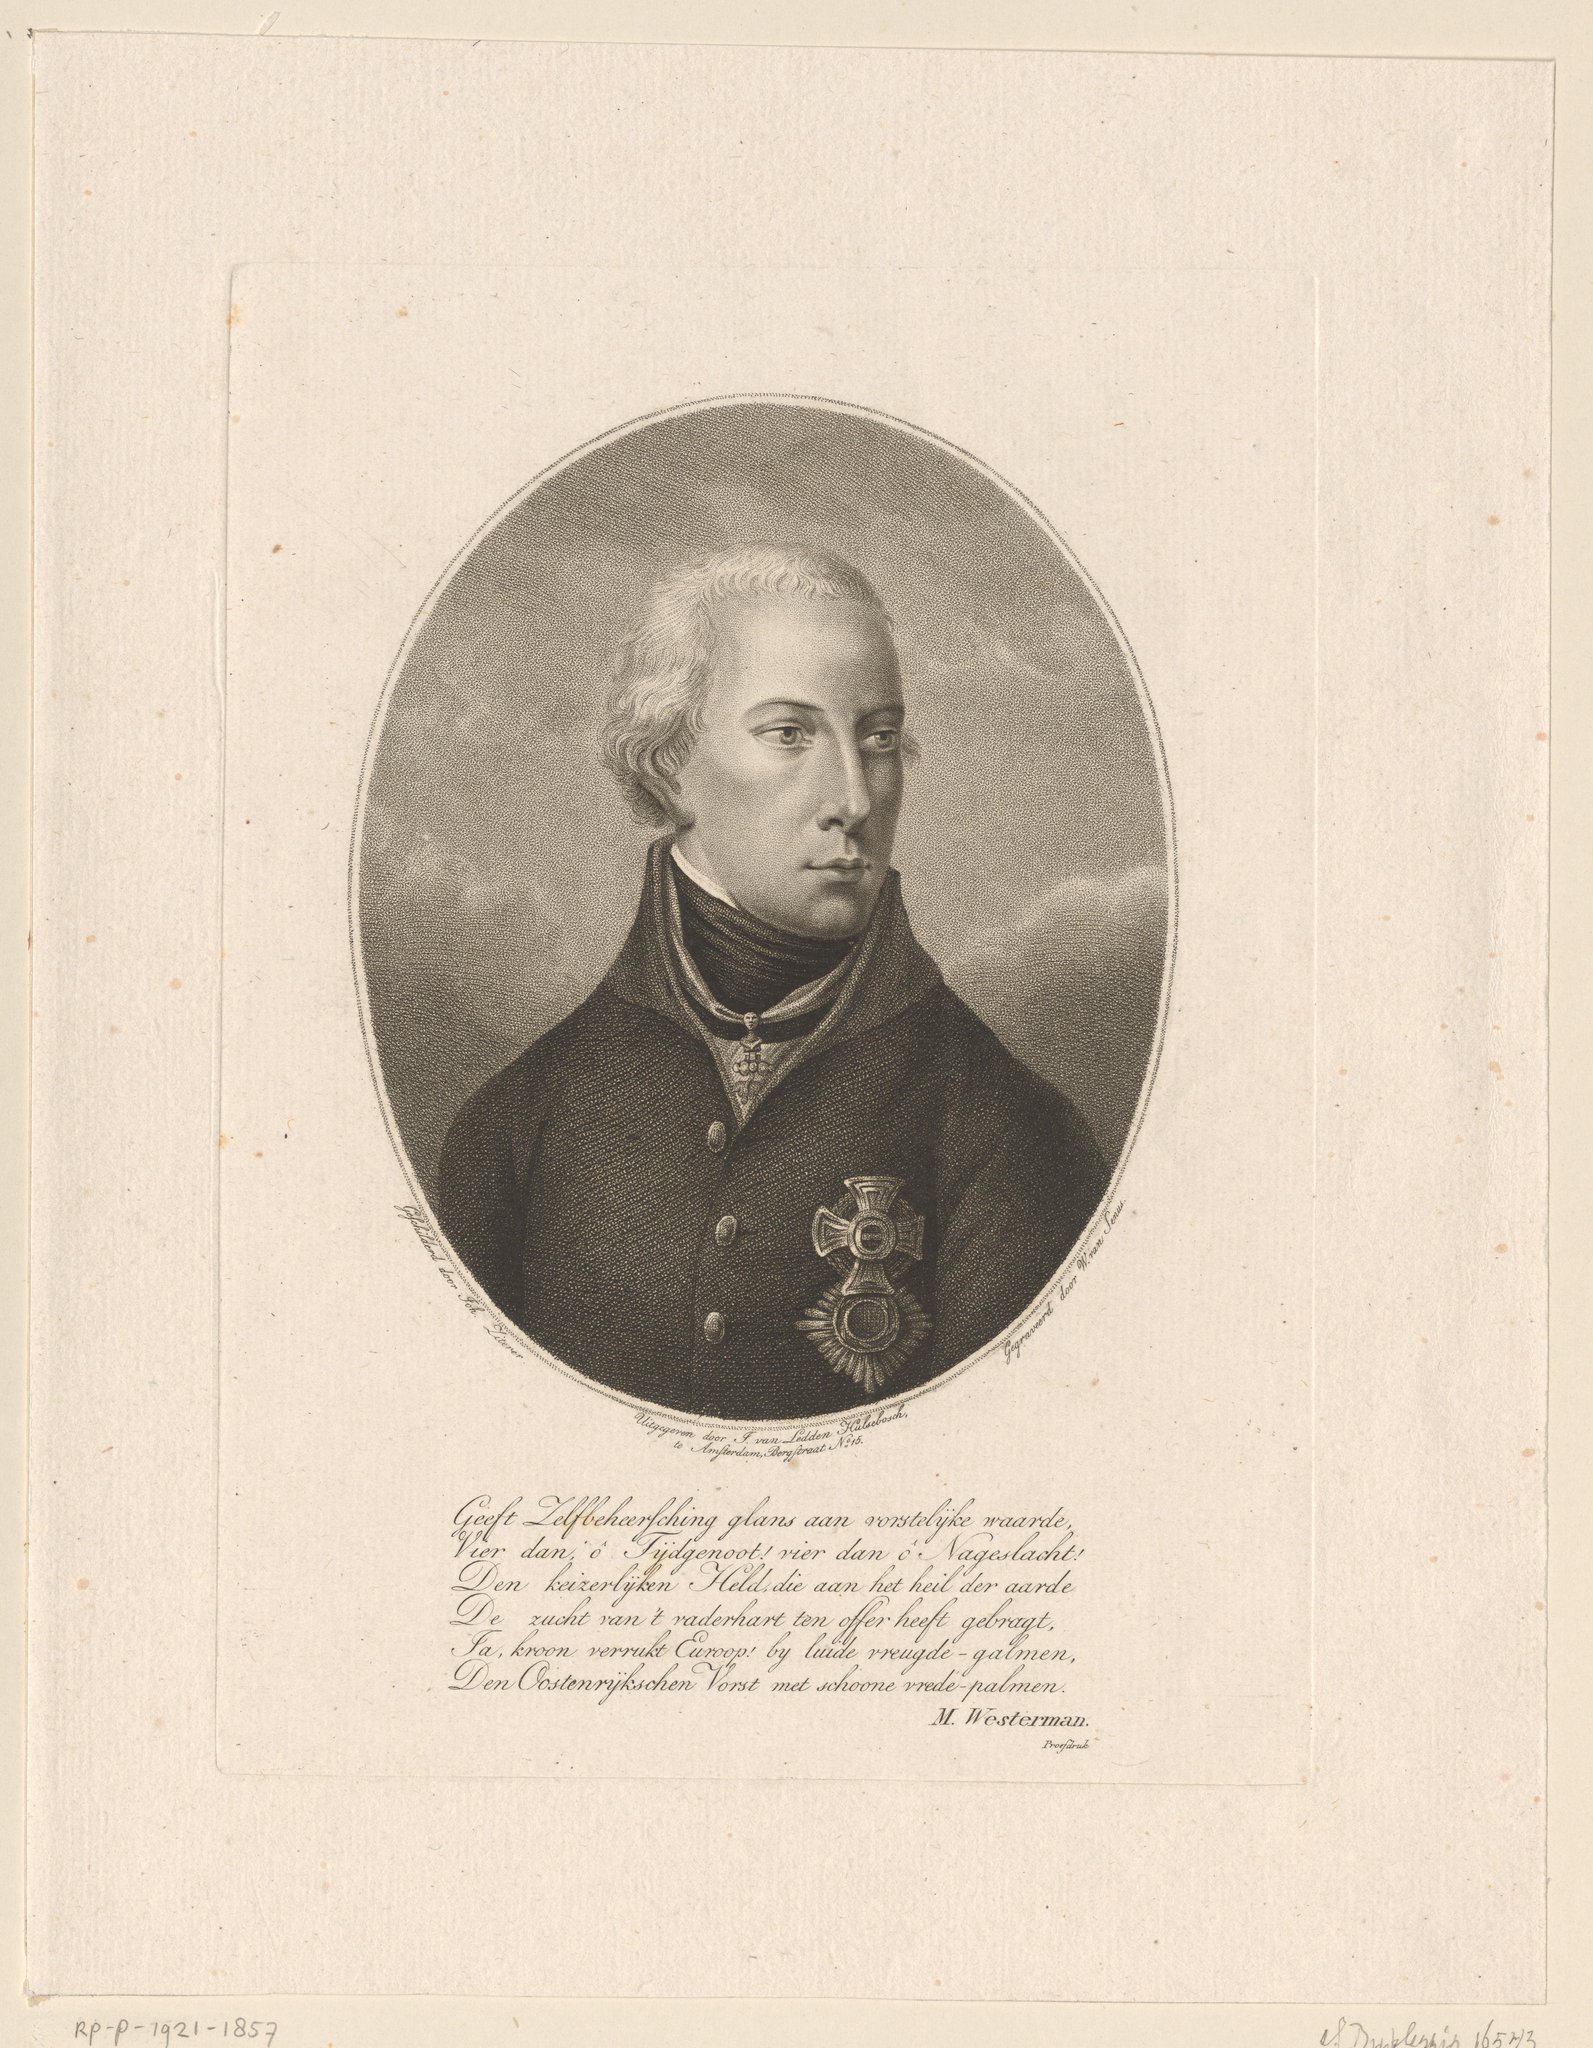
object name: print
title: Portret van Frans I, keizer van Oostenrijk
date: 1804-1819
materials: paper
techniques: engraving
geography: amsterdam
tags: frans ii (rooms-duits keizer), historical persons, emperor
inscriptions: collector's mark: Lugt 2233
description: Met zesregelig lofdicht in het Nederlands onder het portret.